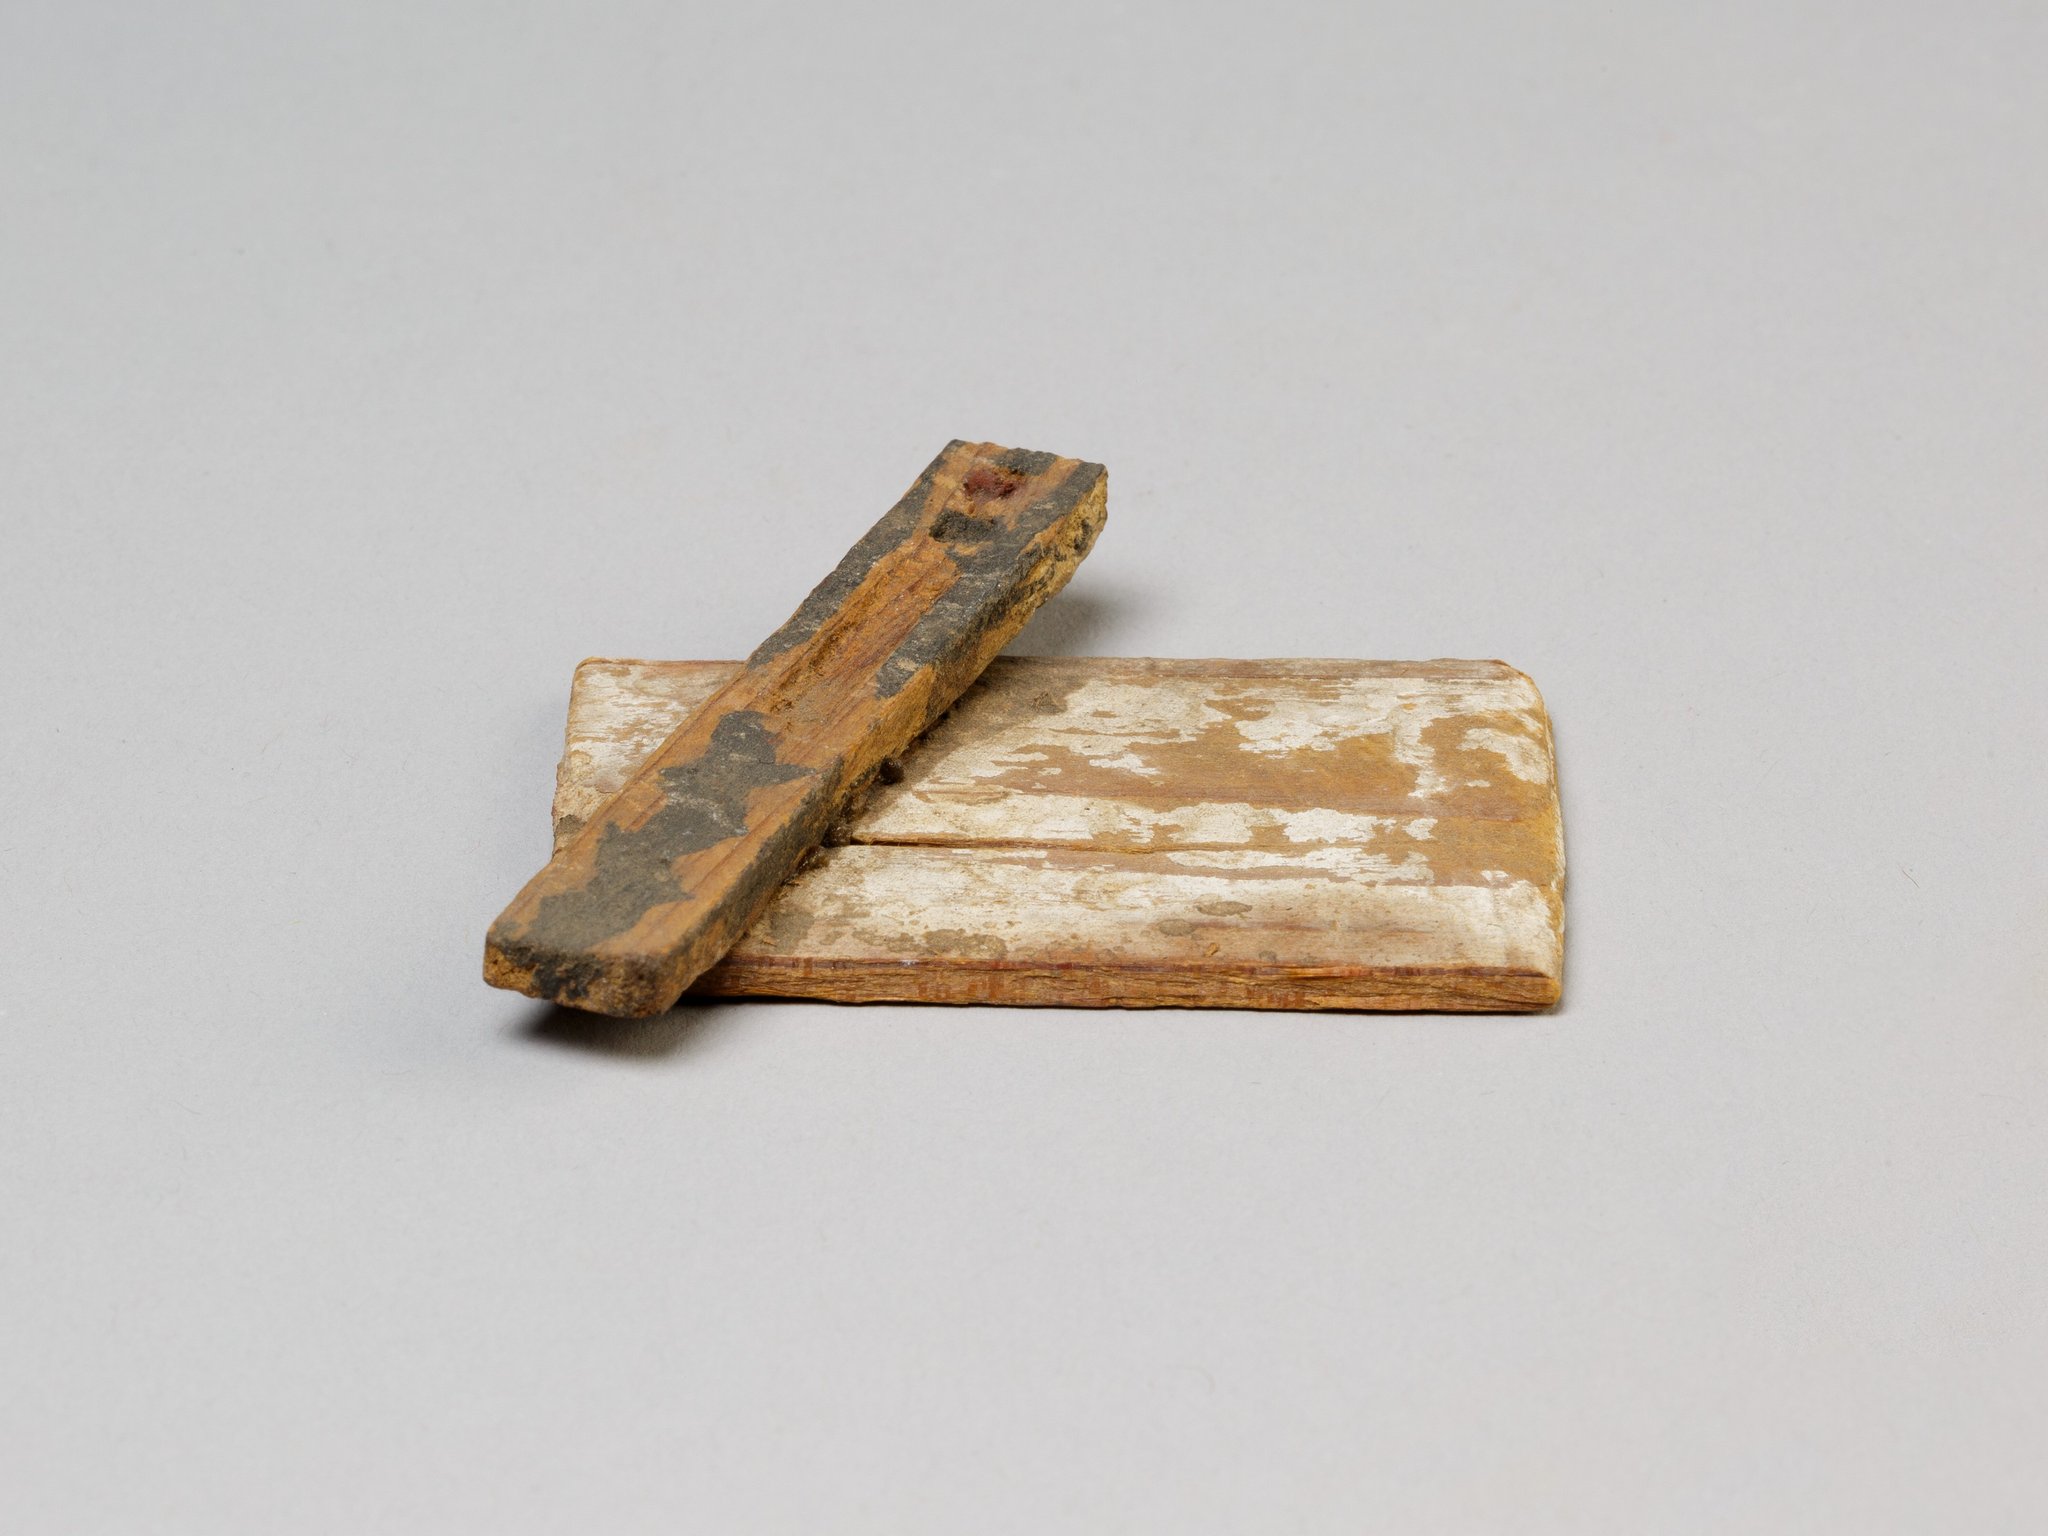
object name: palette and tablet, scribe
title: Model of a Scribe’s Palette and Tablet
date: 2051-1981 BCE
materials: paint, wood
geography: egypt